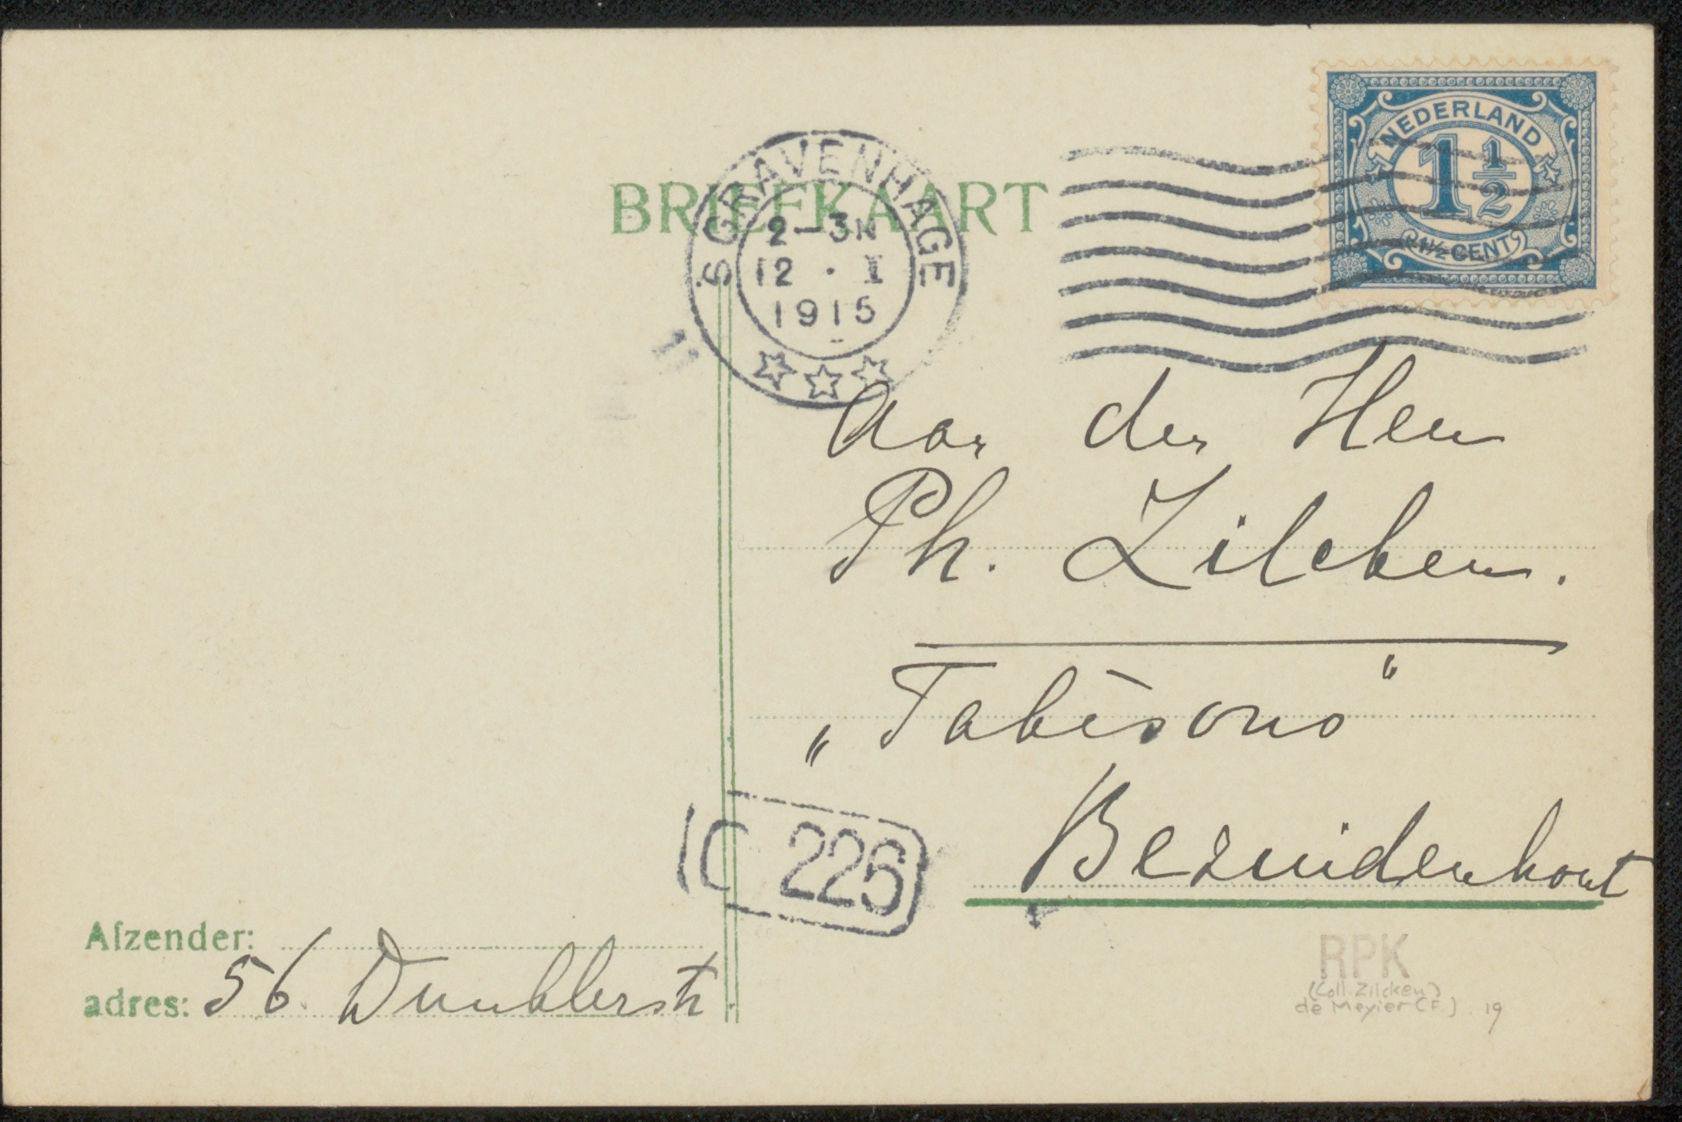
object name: postcard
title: Briefkaart aan Philip Zilcken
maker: fenna de meyier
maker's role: onderwijzer, schrijver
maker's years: 1874-1943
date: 1915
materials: cardboard, ink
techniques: pen, writing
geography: the hague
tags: the hague, painter, draughtsman, philip zilcken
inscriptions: collector's mark: ‘RPK’